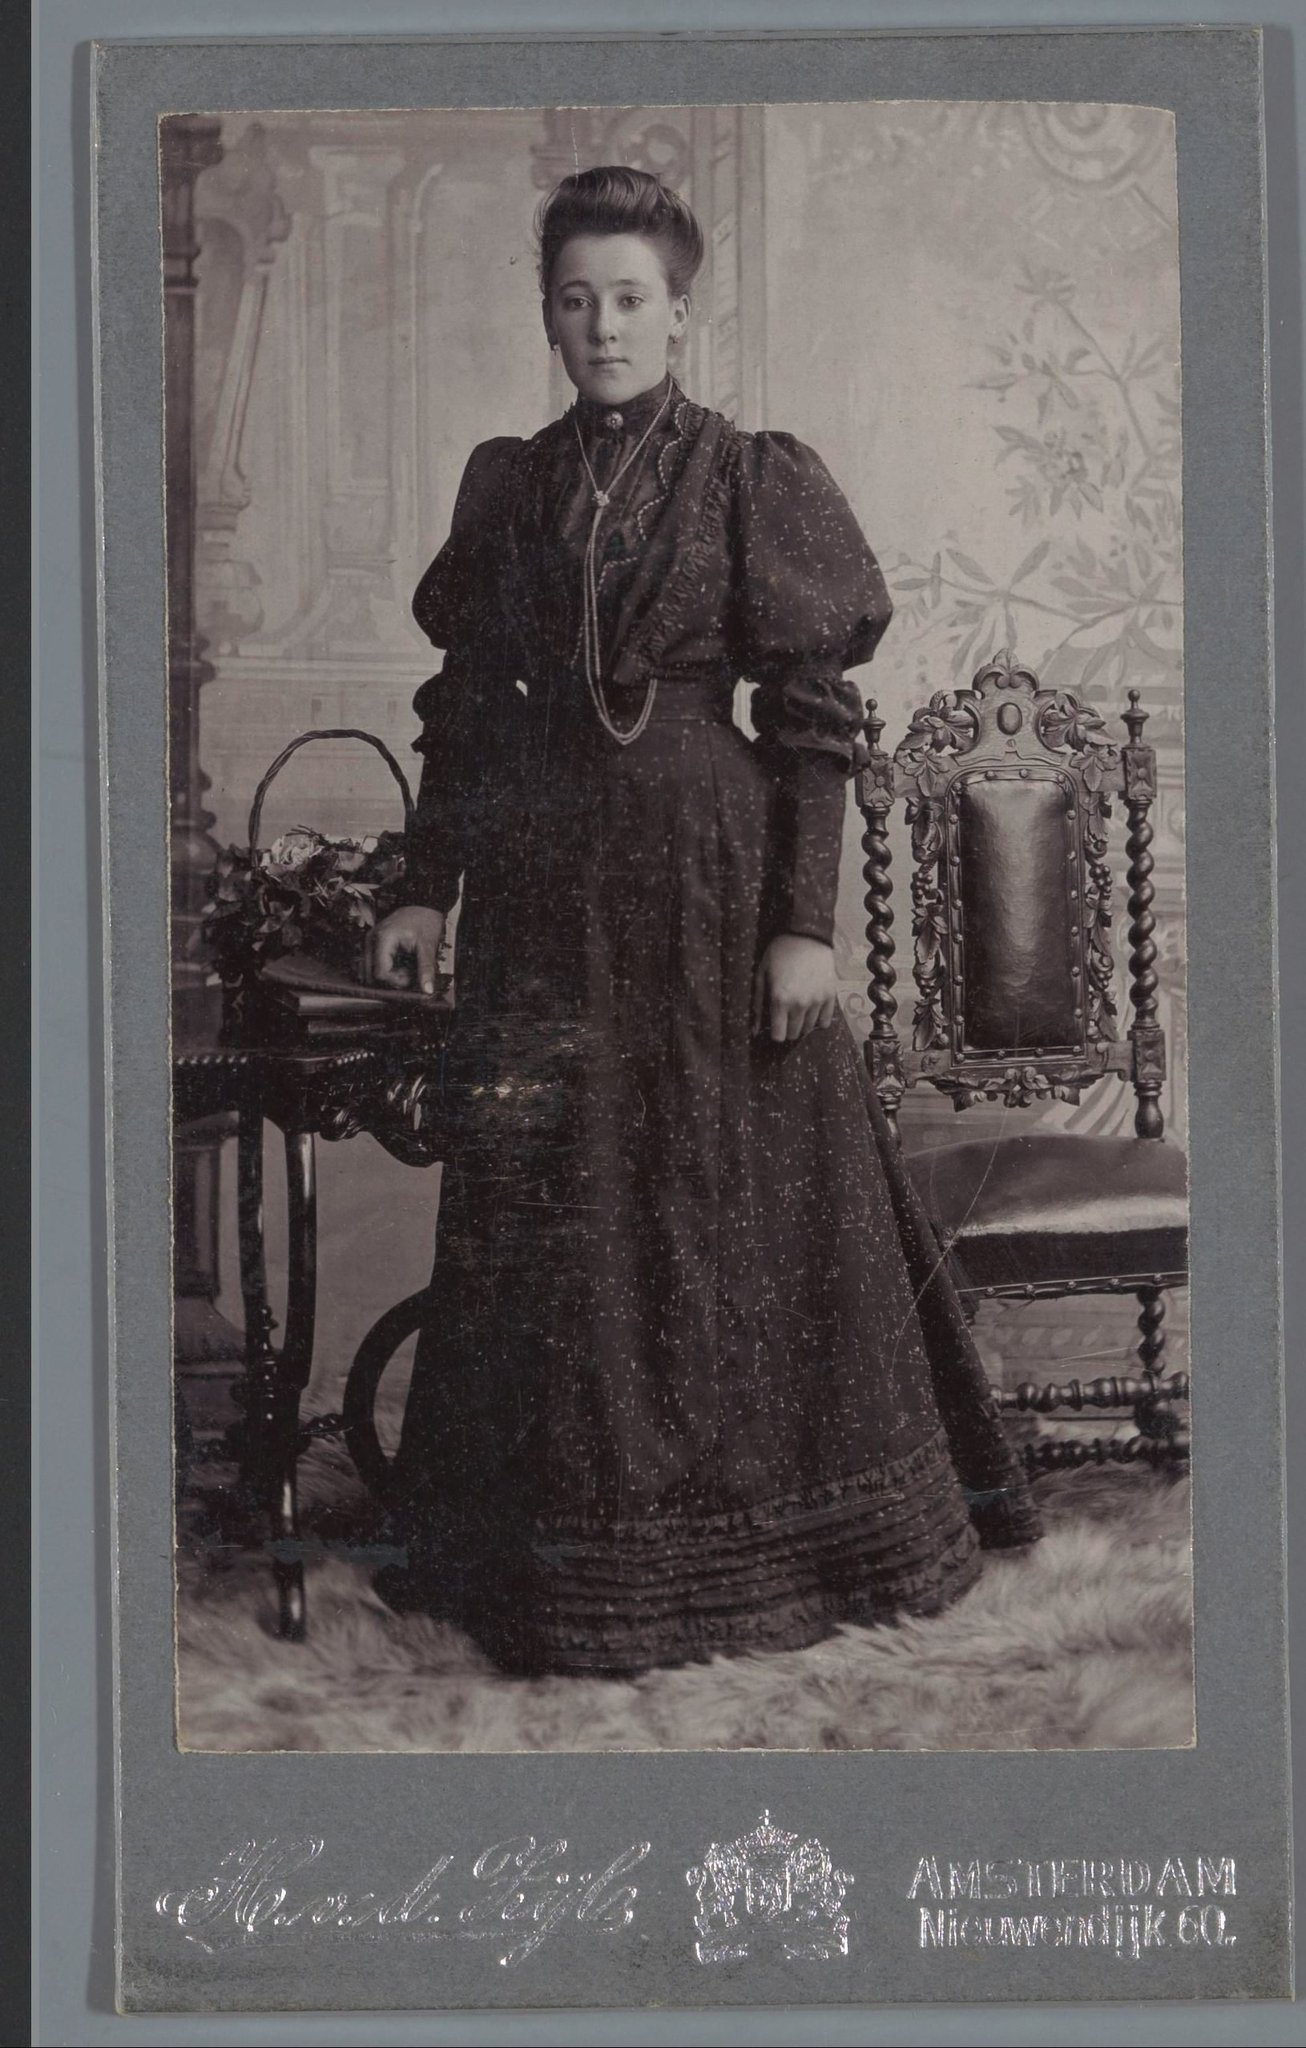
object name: photograph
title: Portret van een onbekende vrouw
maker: h. van der zijl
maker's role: fotograaf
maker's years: 1852-1937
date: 1886-1908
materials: paper, cardboard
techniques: collodion silver print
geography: amsterdam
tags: adult woman, anonymous historical person portrayed, amsterdam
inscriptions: inscription: ‘H. v.d. Zijl/ Amsterdam/ Nieuwendijk 60.’, inscription: ‘Photographie Parisienne/ H. vander Zijl/ Amsterdam/ 60. Nieuwendijk/ bij de Martelaarsgracht./ Gelieve op voornaam H en Huisnummer 60 te letten./ 4205 Prager & Lojda, Berlin.’